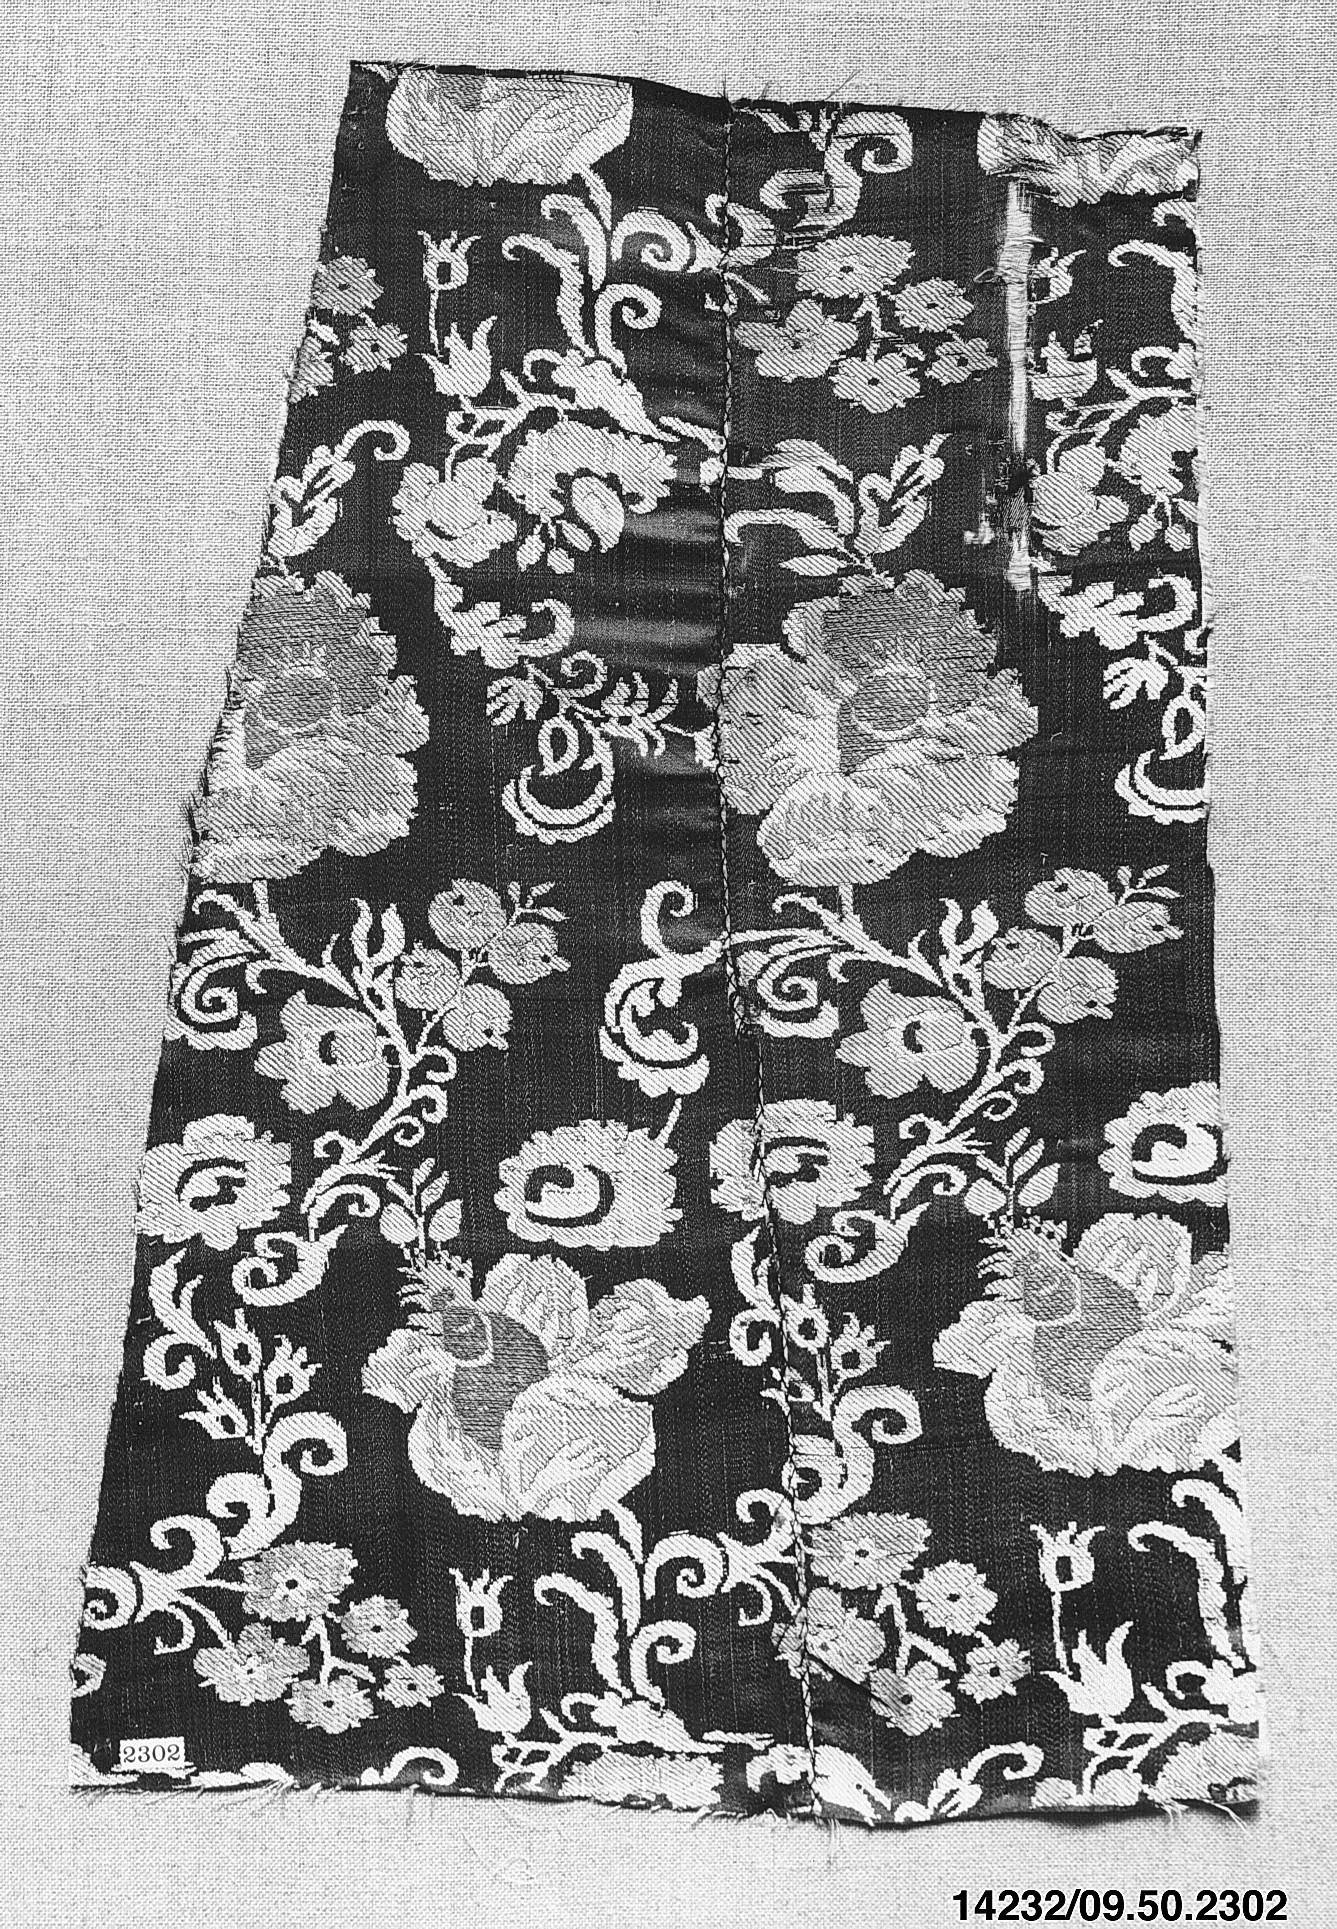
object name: piece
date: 1701-1733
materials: metal thread, silk